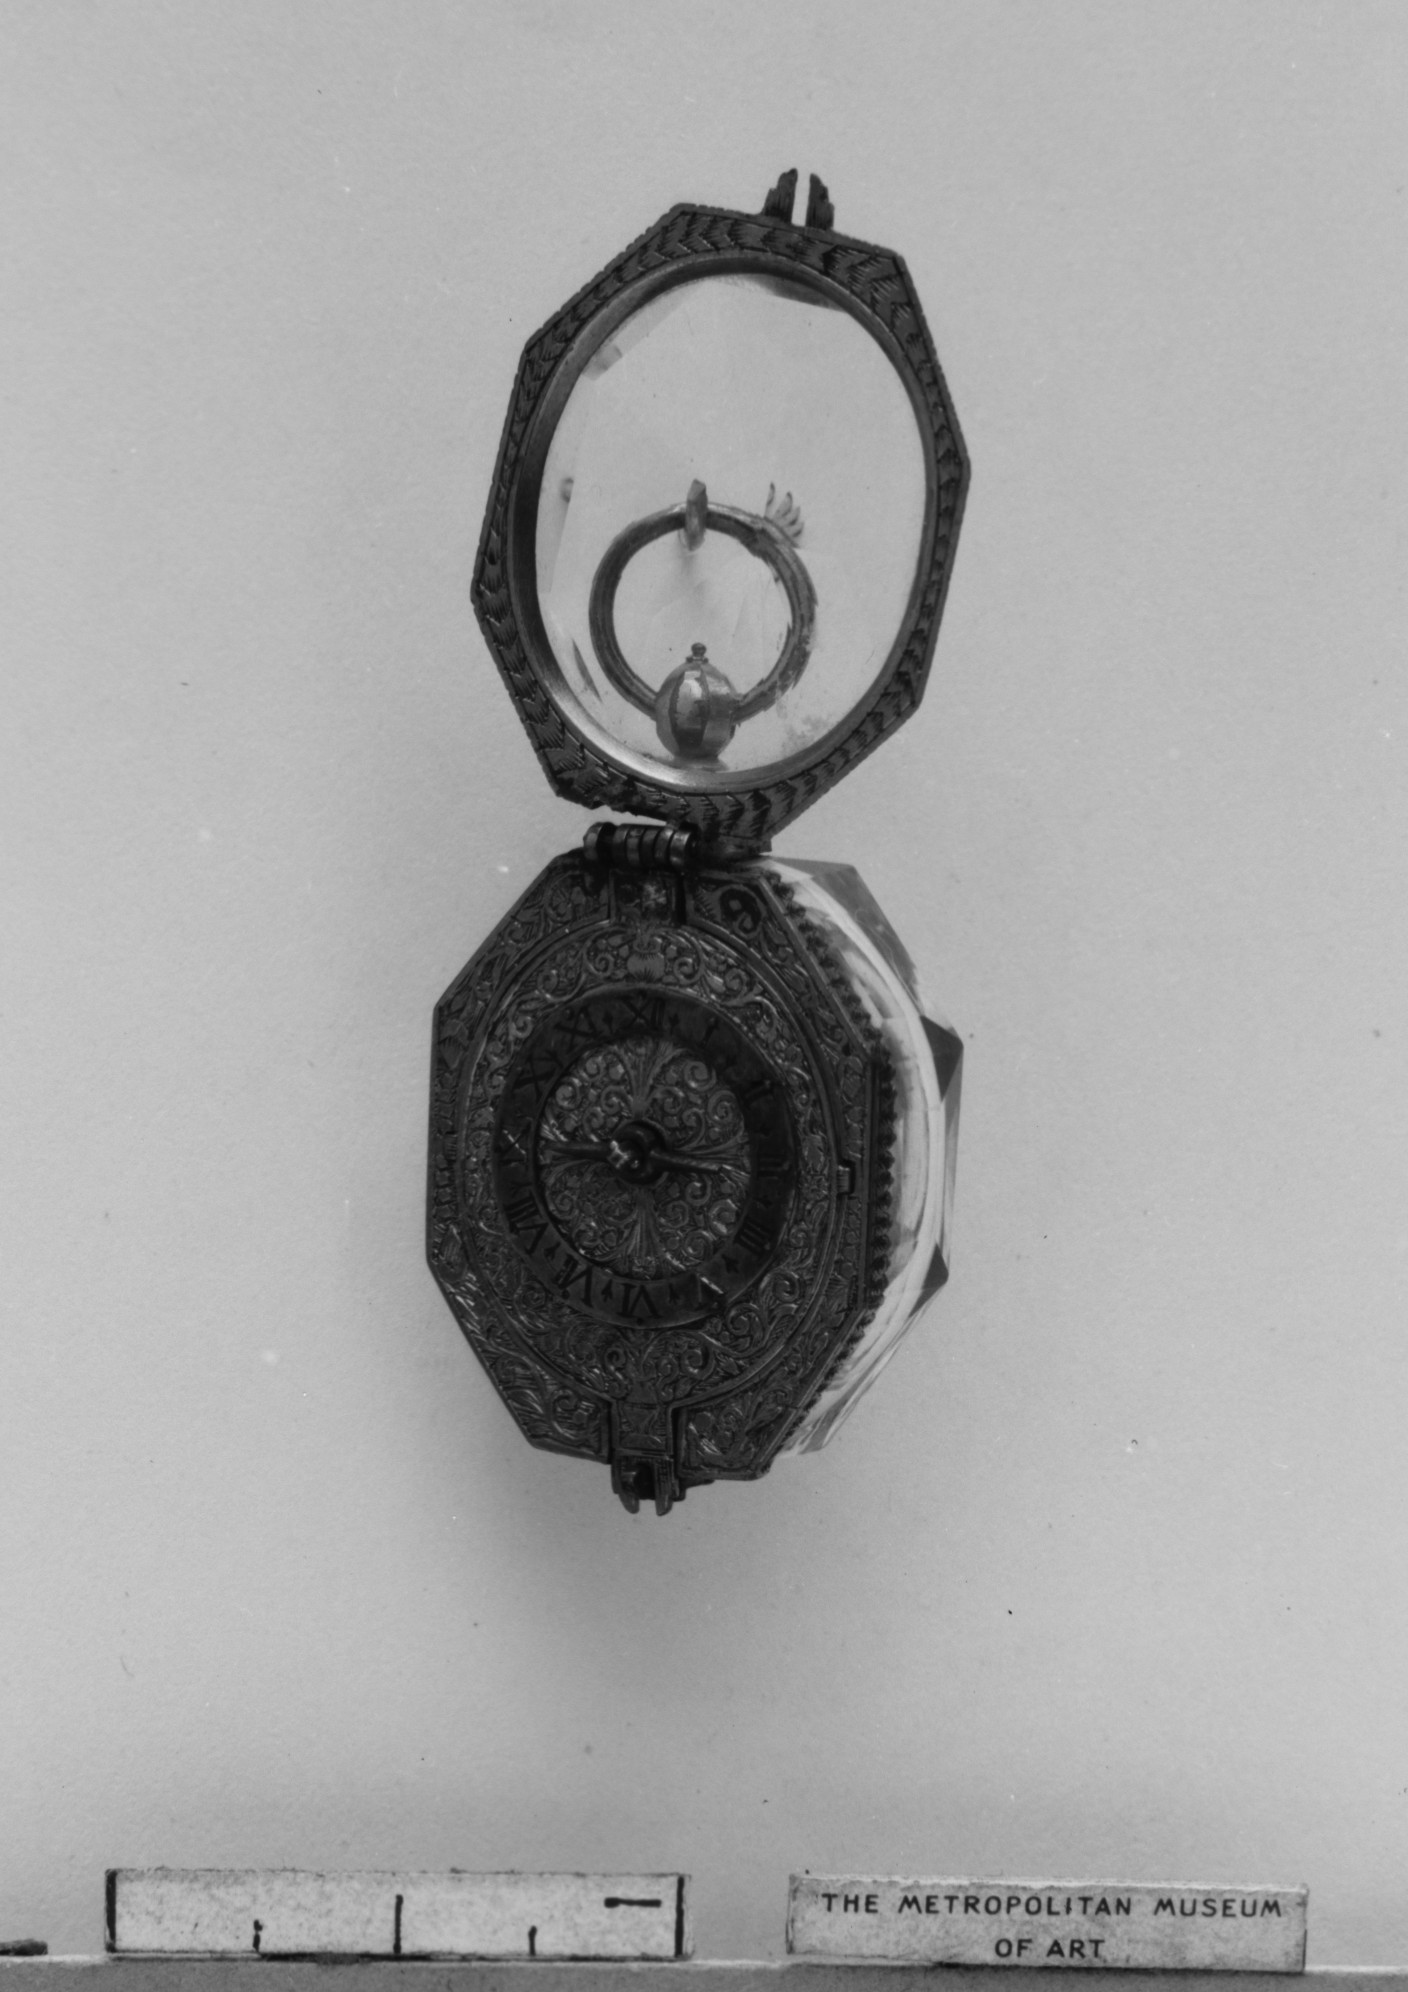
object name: watch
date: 1620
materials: gilt, metal, quartz, silver